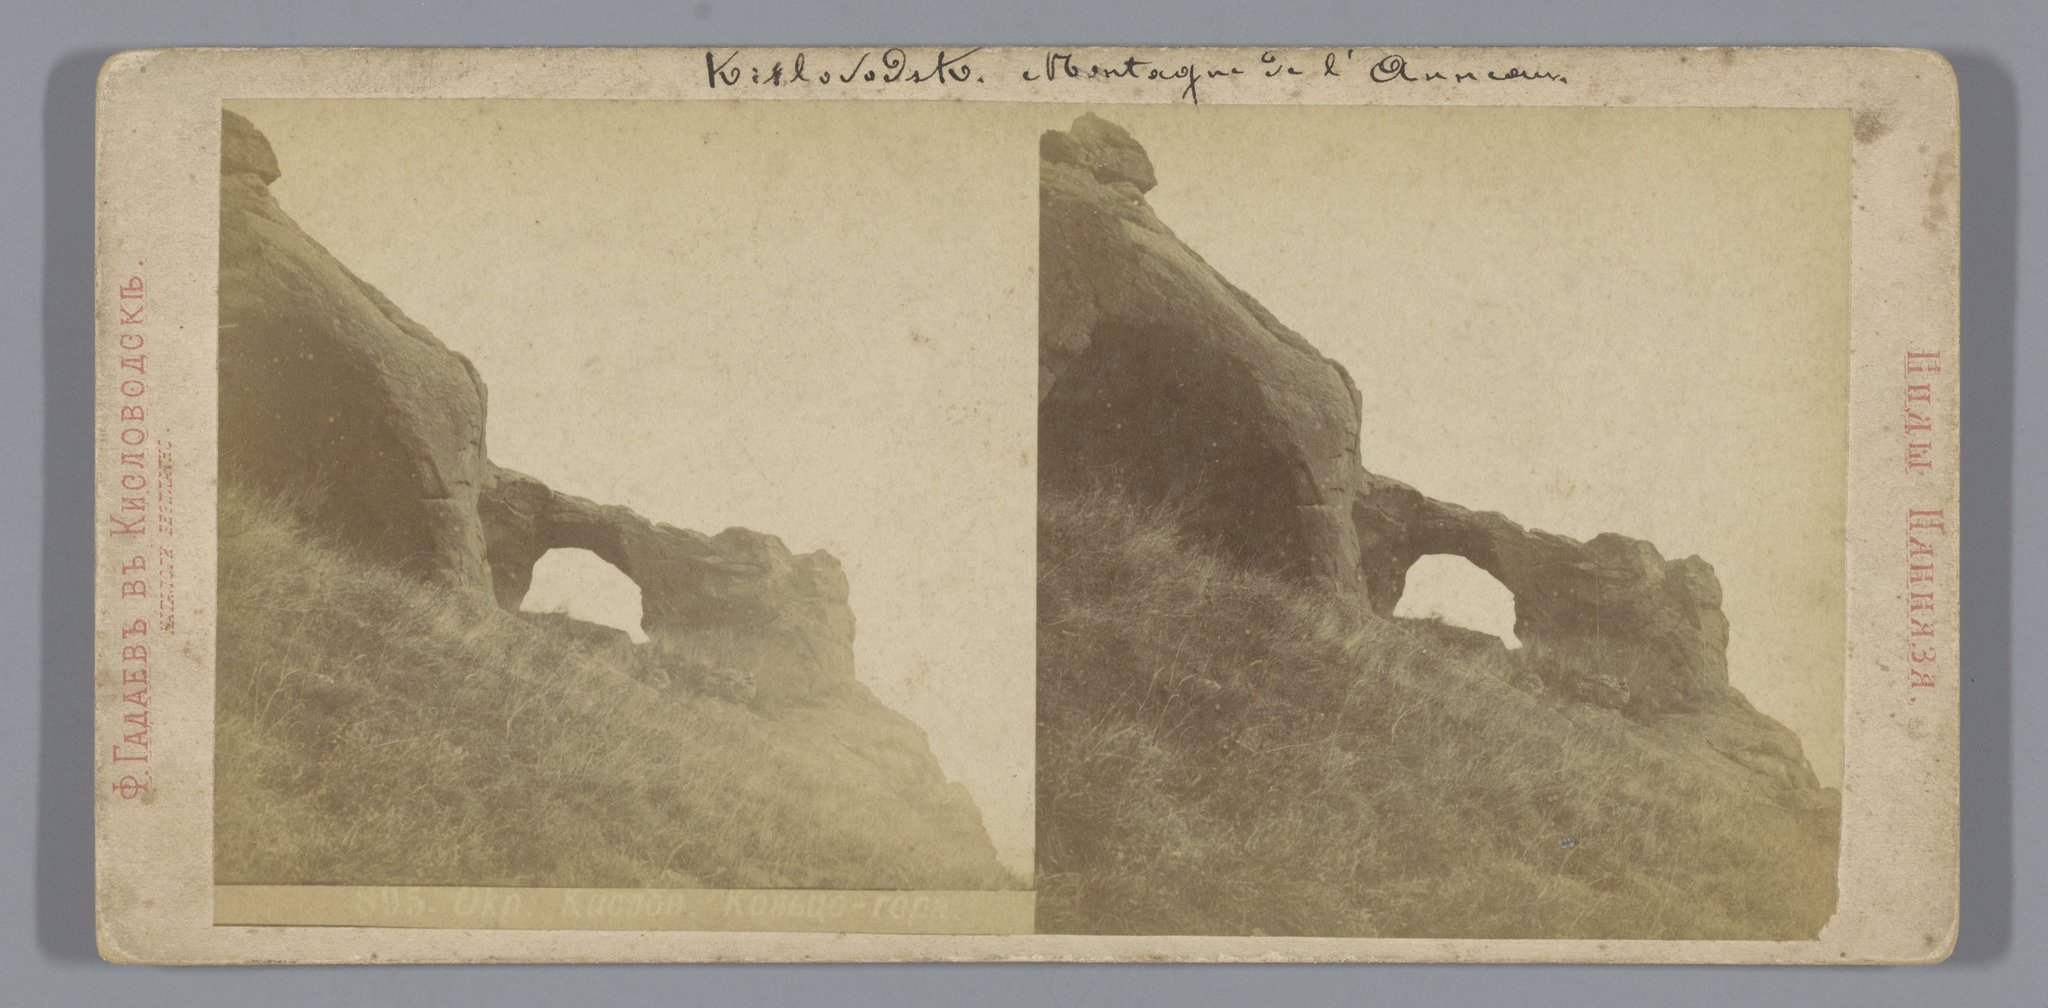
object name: stereograph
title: Okr. Kuslow. Koptso-gora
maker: f. gadajew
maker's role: fotograaf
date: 1850-1880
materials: cardboard, photographic support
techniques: albumen print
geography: russia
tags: mountains, russia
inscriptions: number: ‘895.’, inscription: ‘Kislovodsk. Montagne de l'Anneau.’